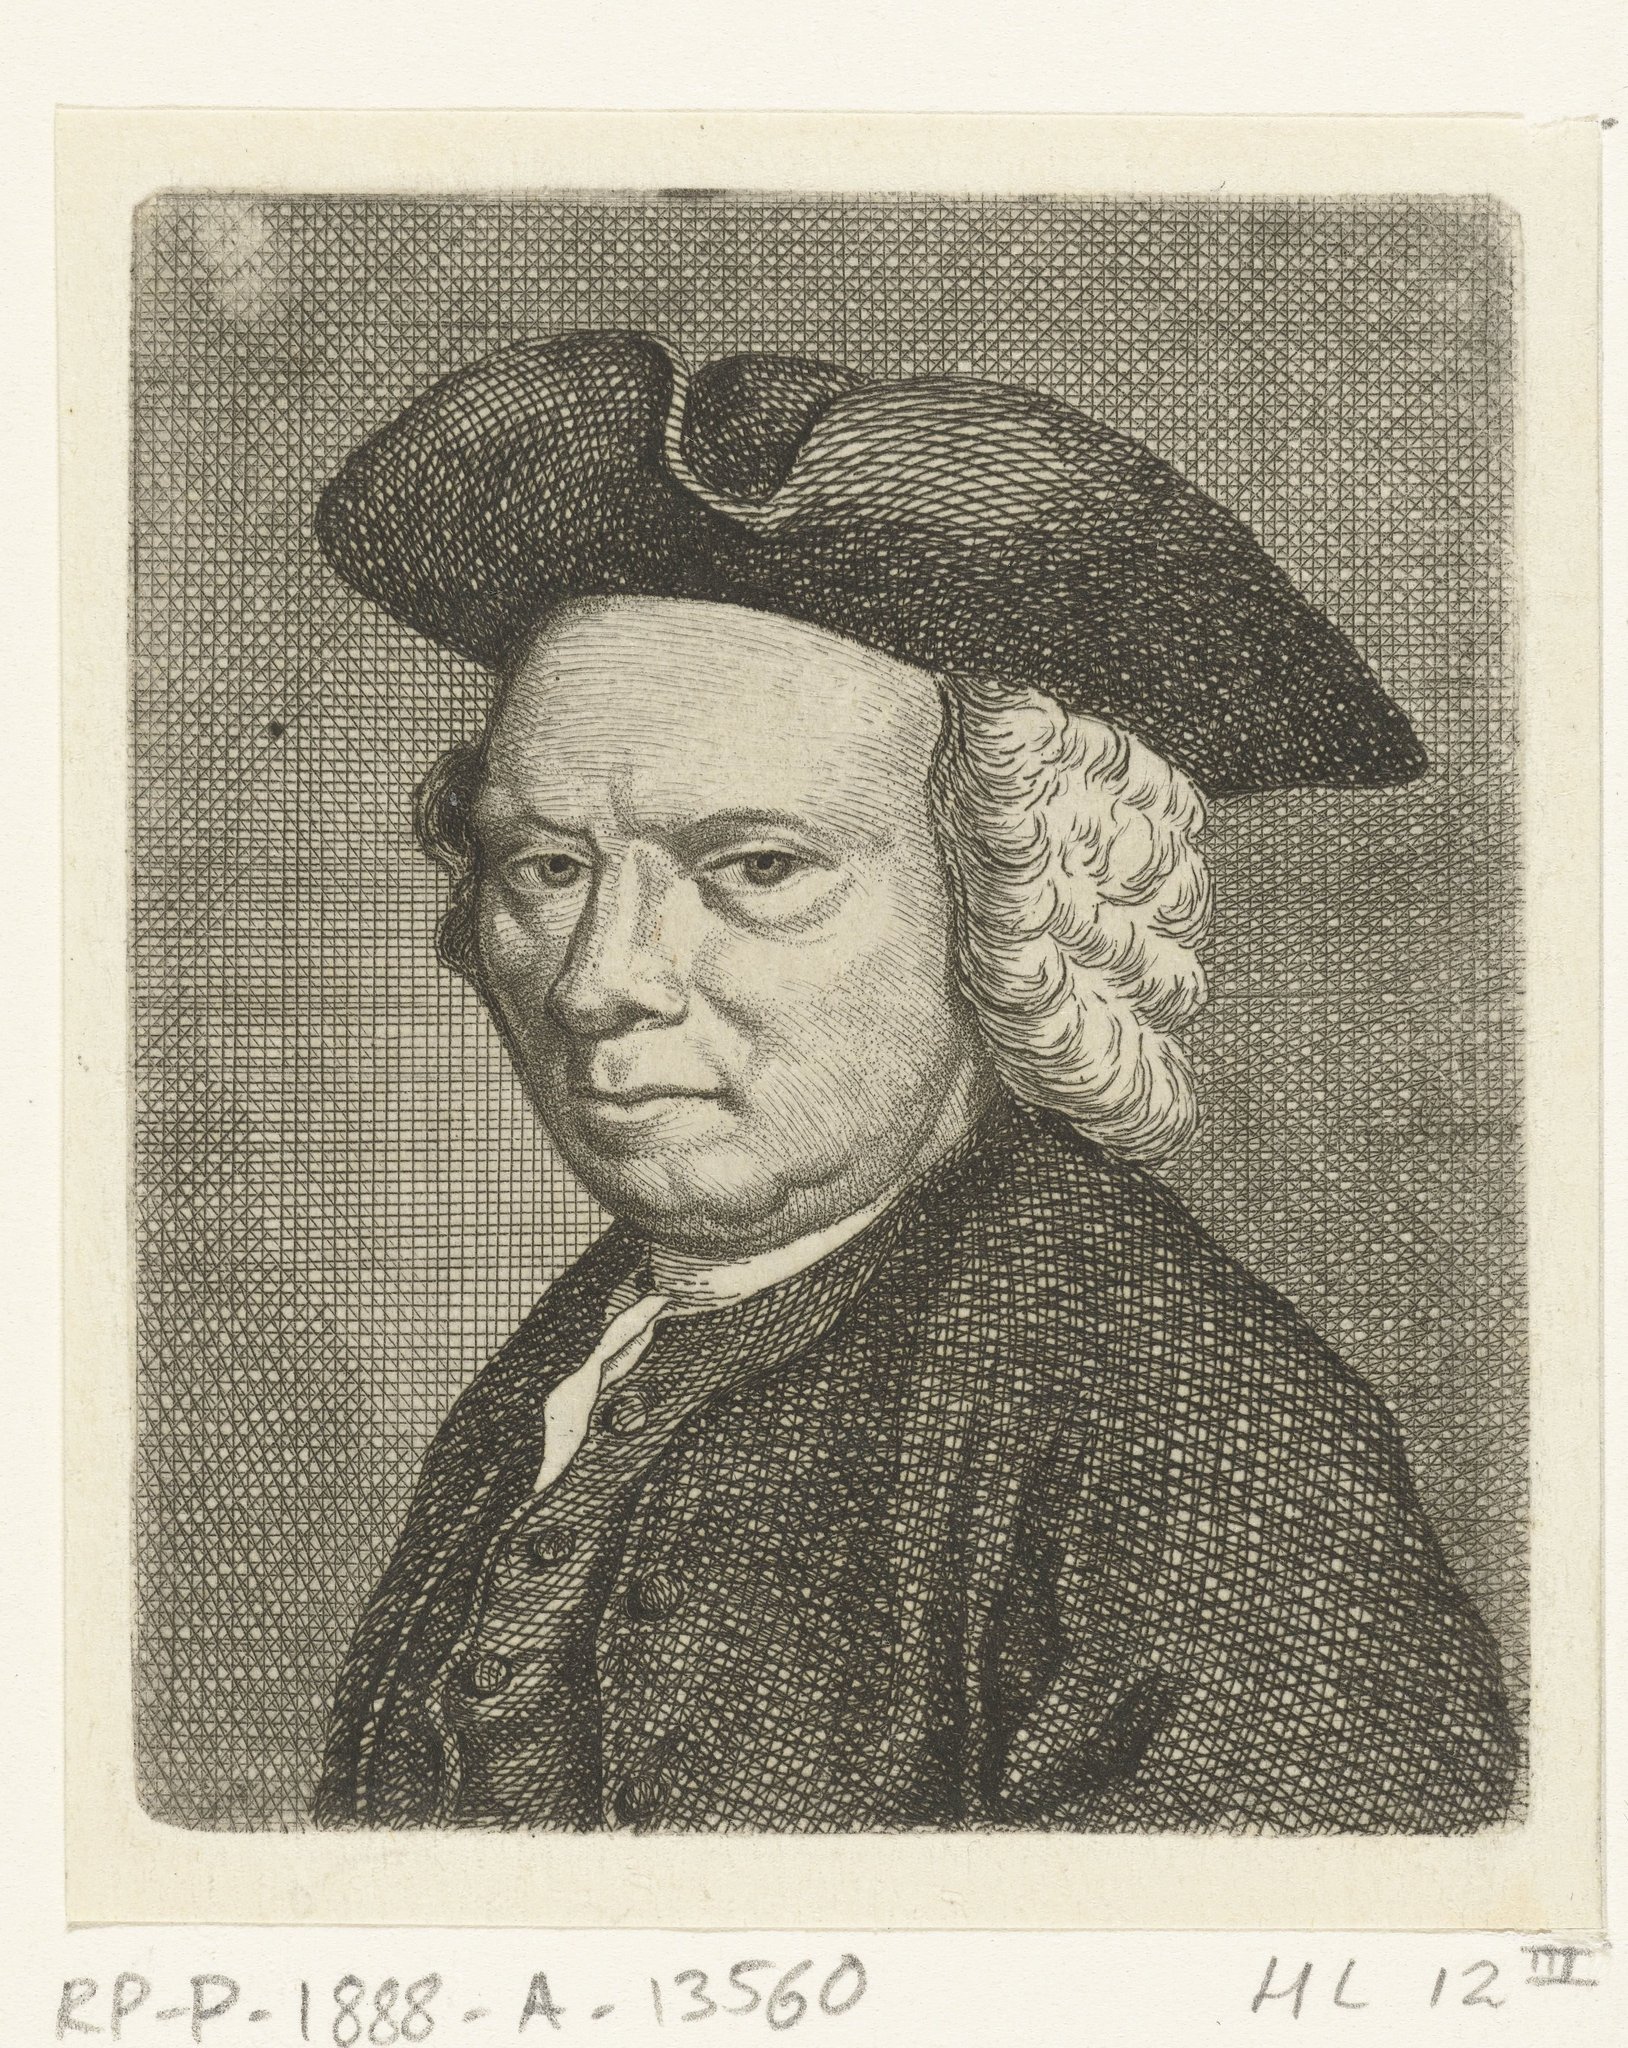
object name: print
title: Portret van Hendrik Tavenier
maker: ernst willem jan bagelaar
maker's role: draughtsman, print maker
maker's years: 1775-1837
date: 1798-1837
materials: paper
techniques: etching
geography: netherlands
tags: paris, painter, print maker, draughtsman, publisher, herman van swanevelt, hendrik tavenier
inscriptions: collector's mark: Lugt 2228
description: Volgens Hippert&Linnig portret van Van Swanevelt, achter op twee van de verschillende staten wordt echter H. Tavenier genoemd als de geportretteerde